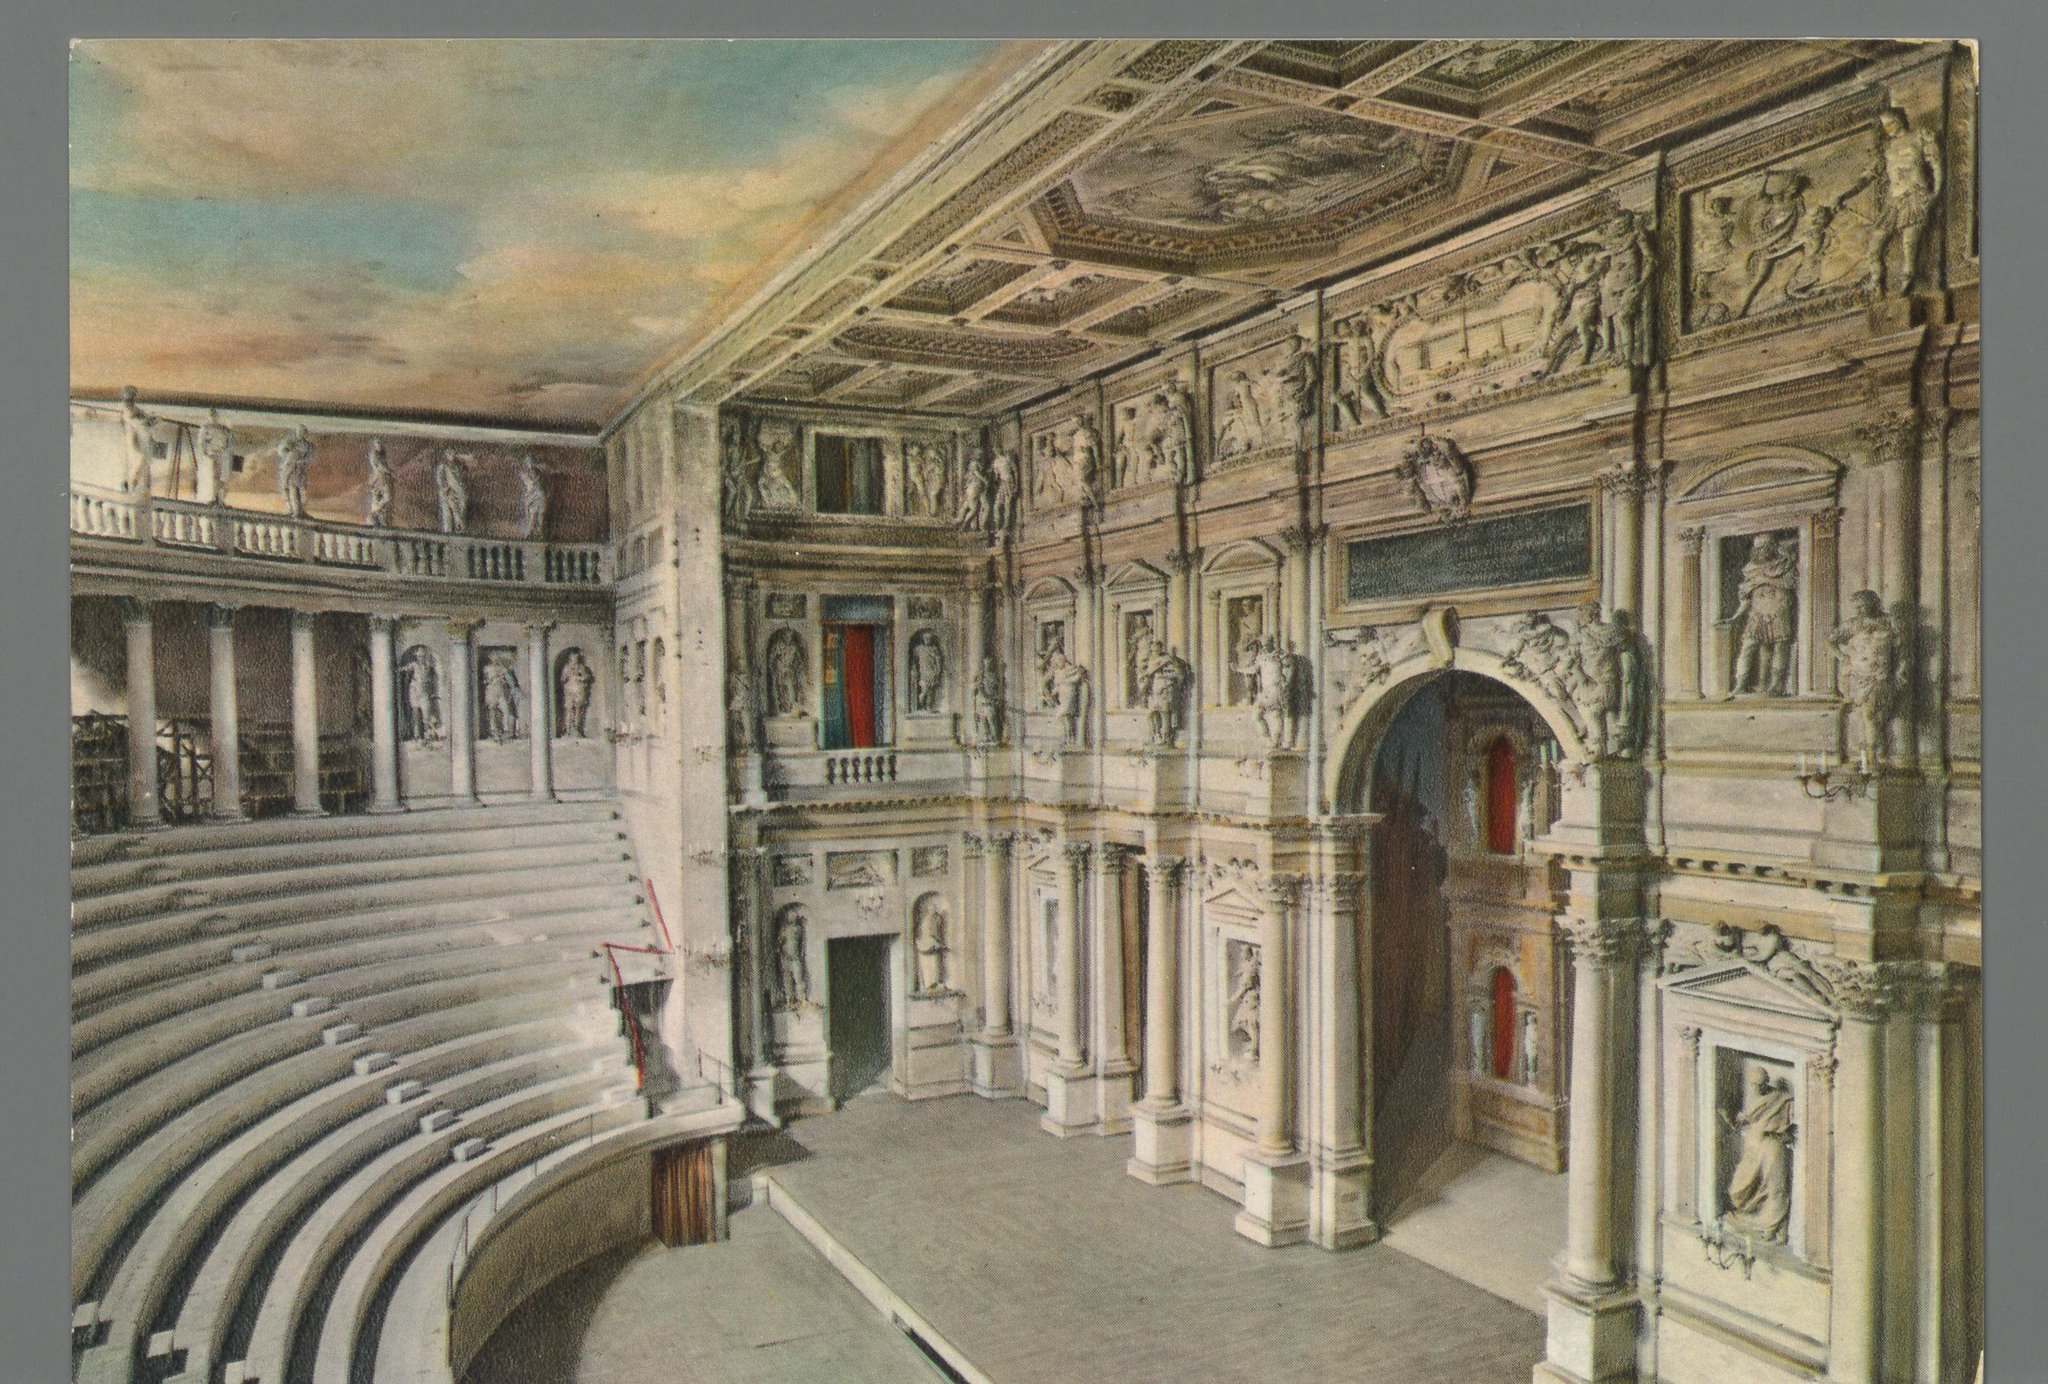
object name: photomechanical print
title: Vicenza. Interno Theatro Olimpico (Palladio) / Avant-scène Théâtre Olympique (Palladio) / Vorbühne Olympisches Theater (Palladio) / Stage Olimpic Theatre (Palladio)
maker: Anonymous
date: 1950-1979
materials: cardboard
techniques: offset printed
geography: vicenza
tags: theatre (building), stage design